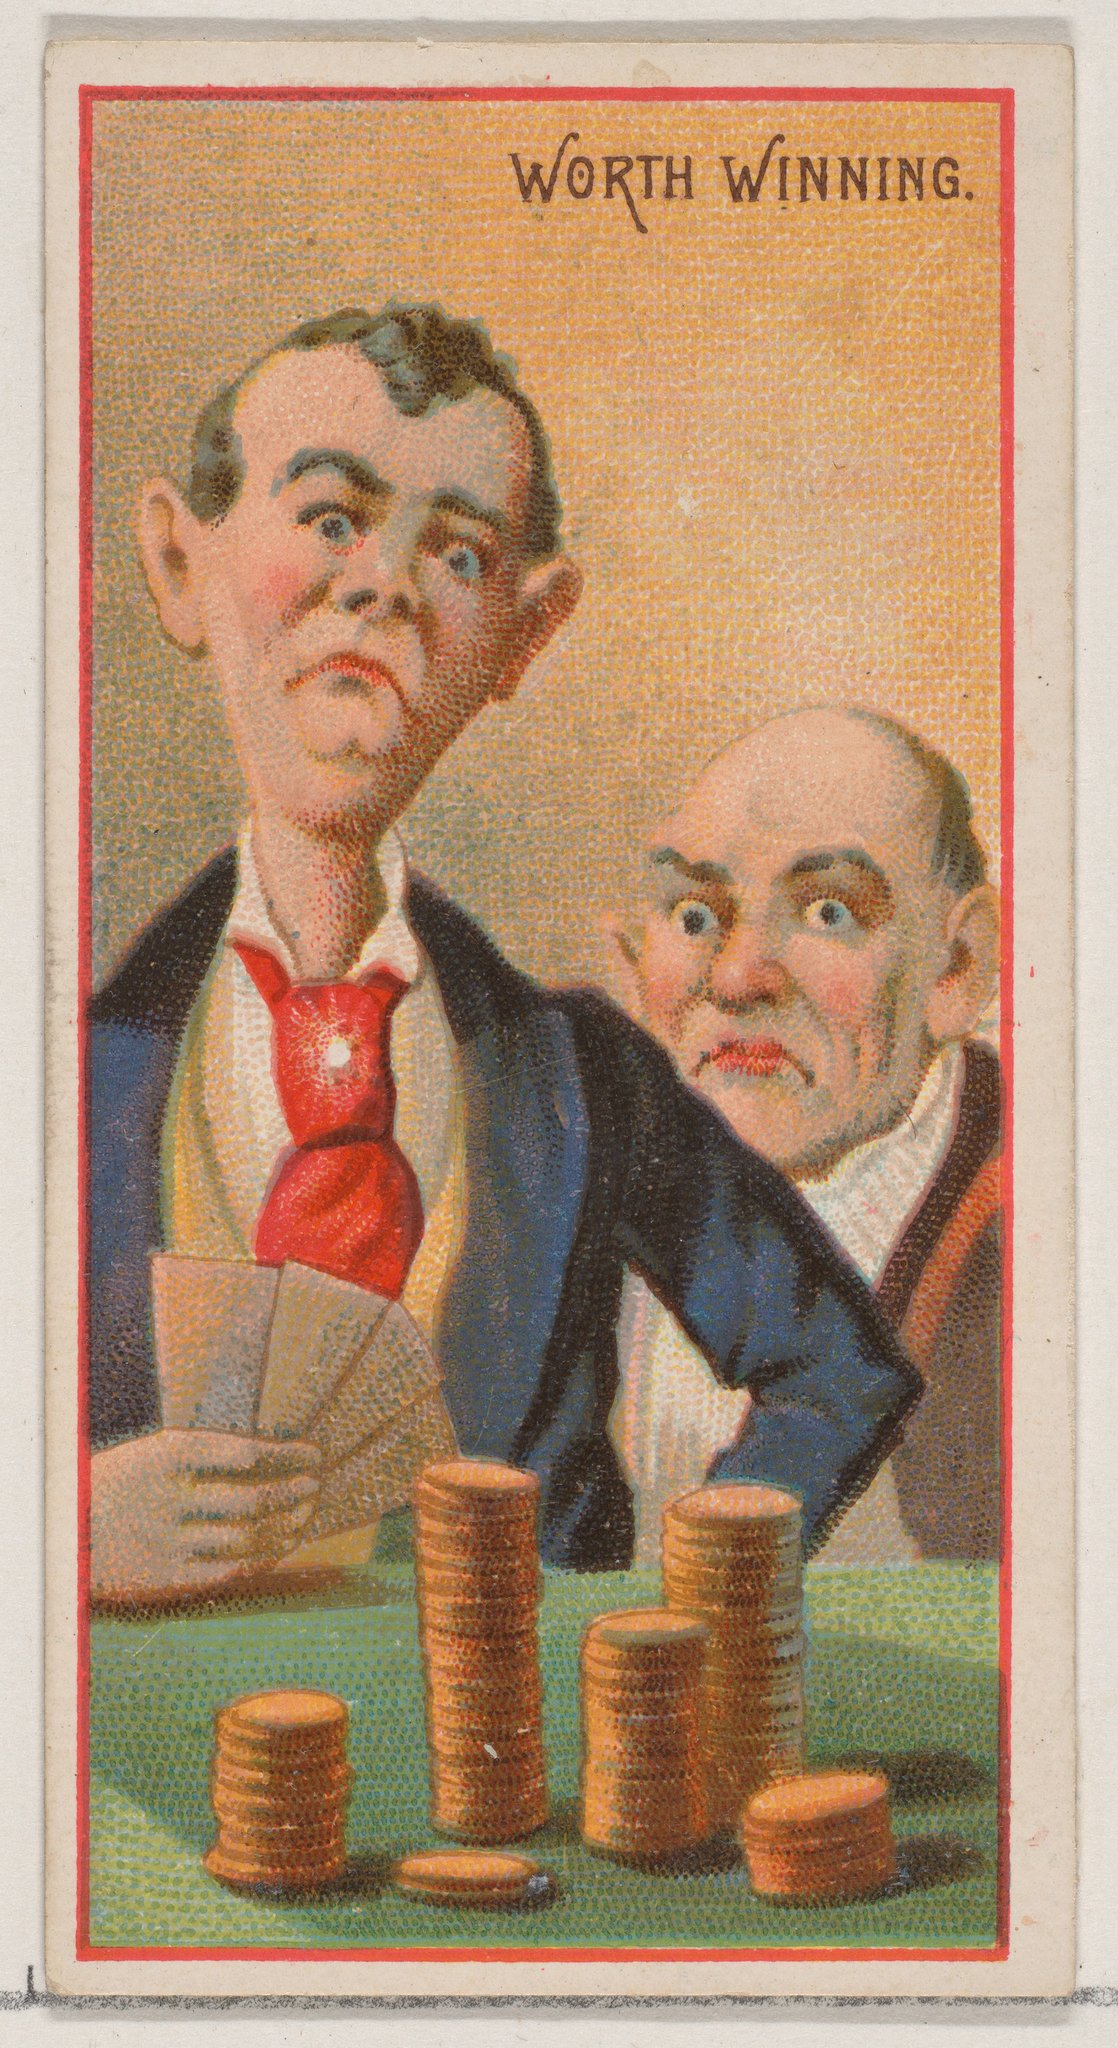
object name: print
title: Worth Winning, from the Jokes series (N87) for Duke brand cigarettes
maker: w. duke, sons & co.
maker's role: publisher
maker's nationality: american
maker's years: 1870-1920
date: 1890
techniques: color lithograph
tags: men,gambling